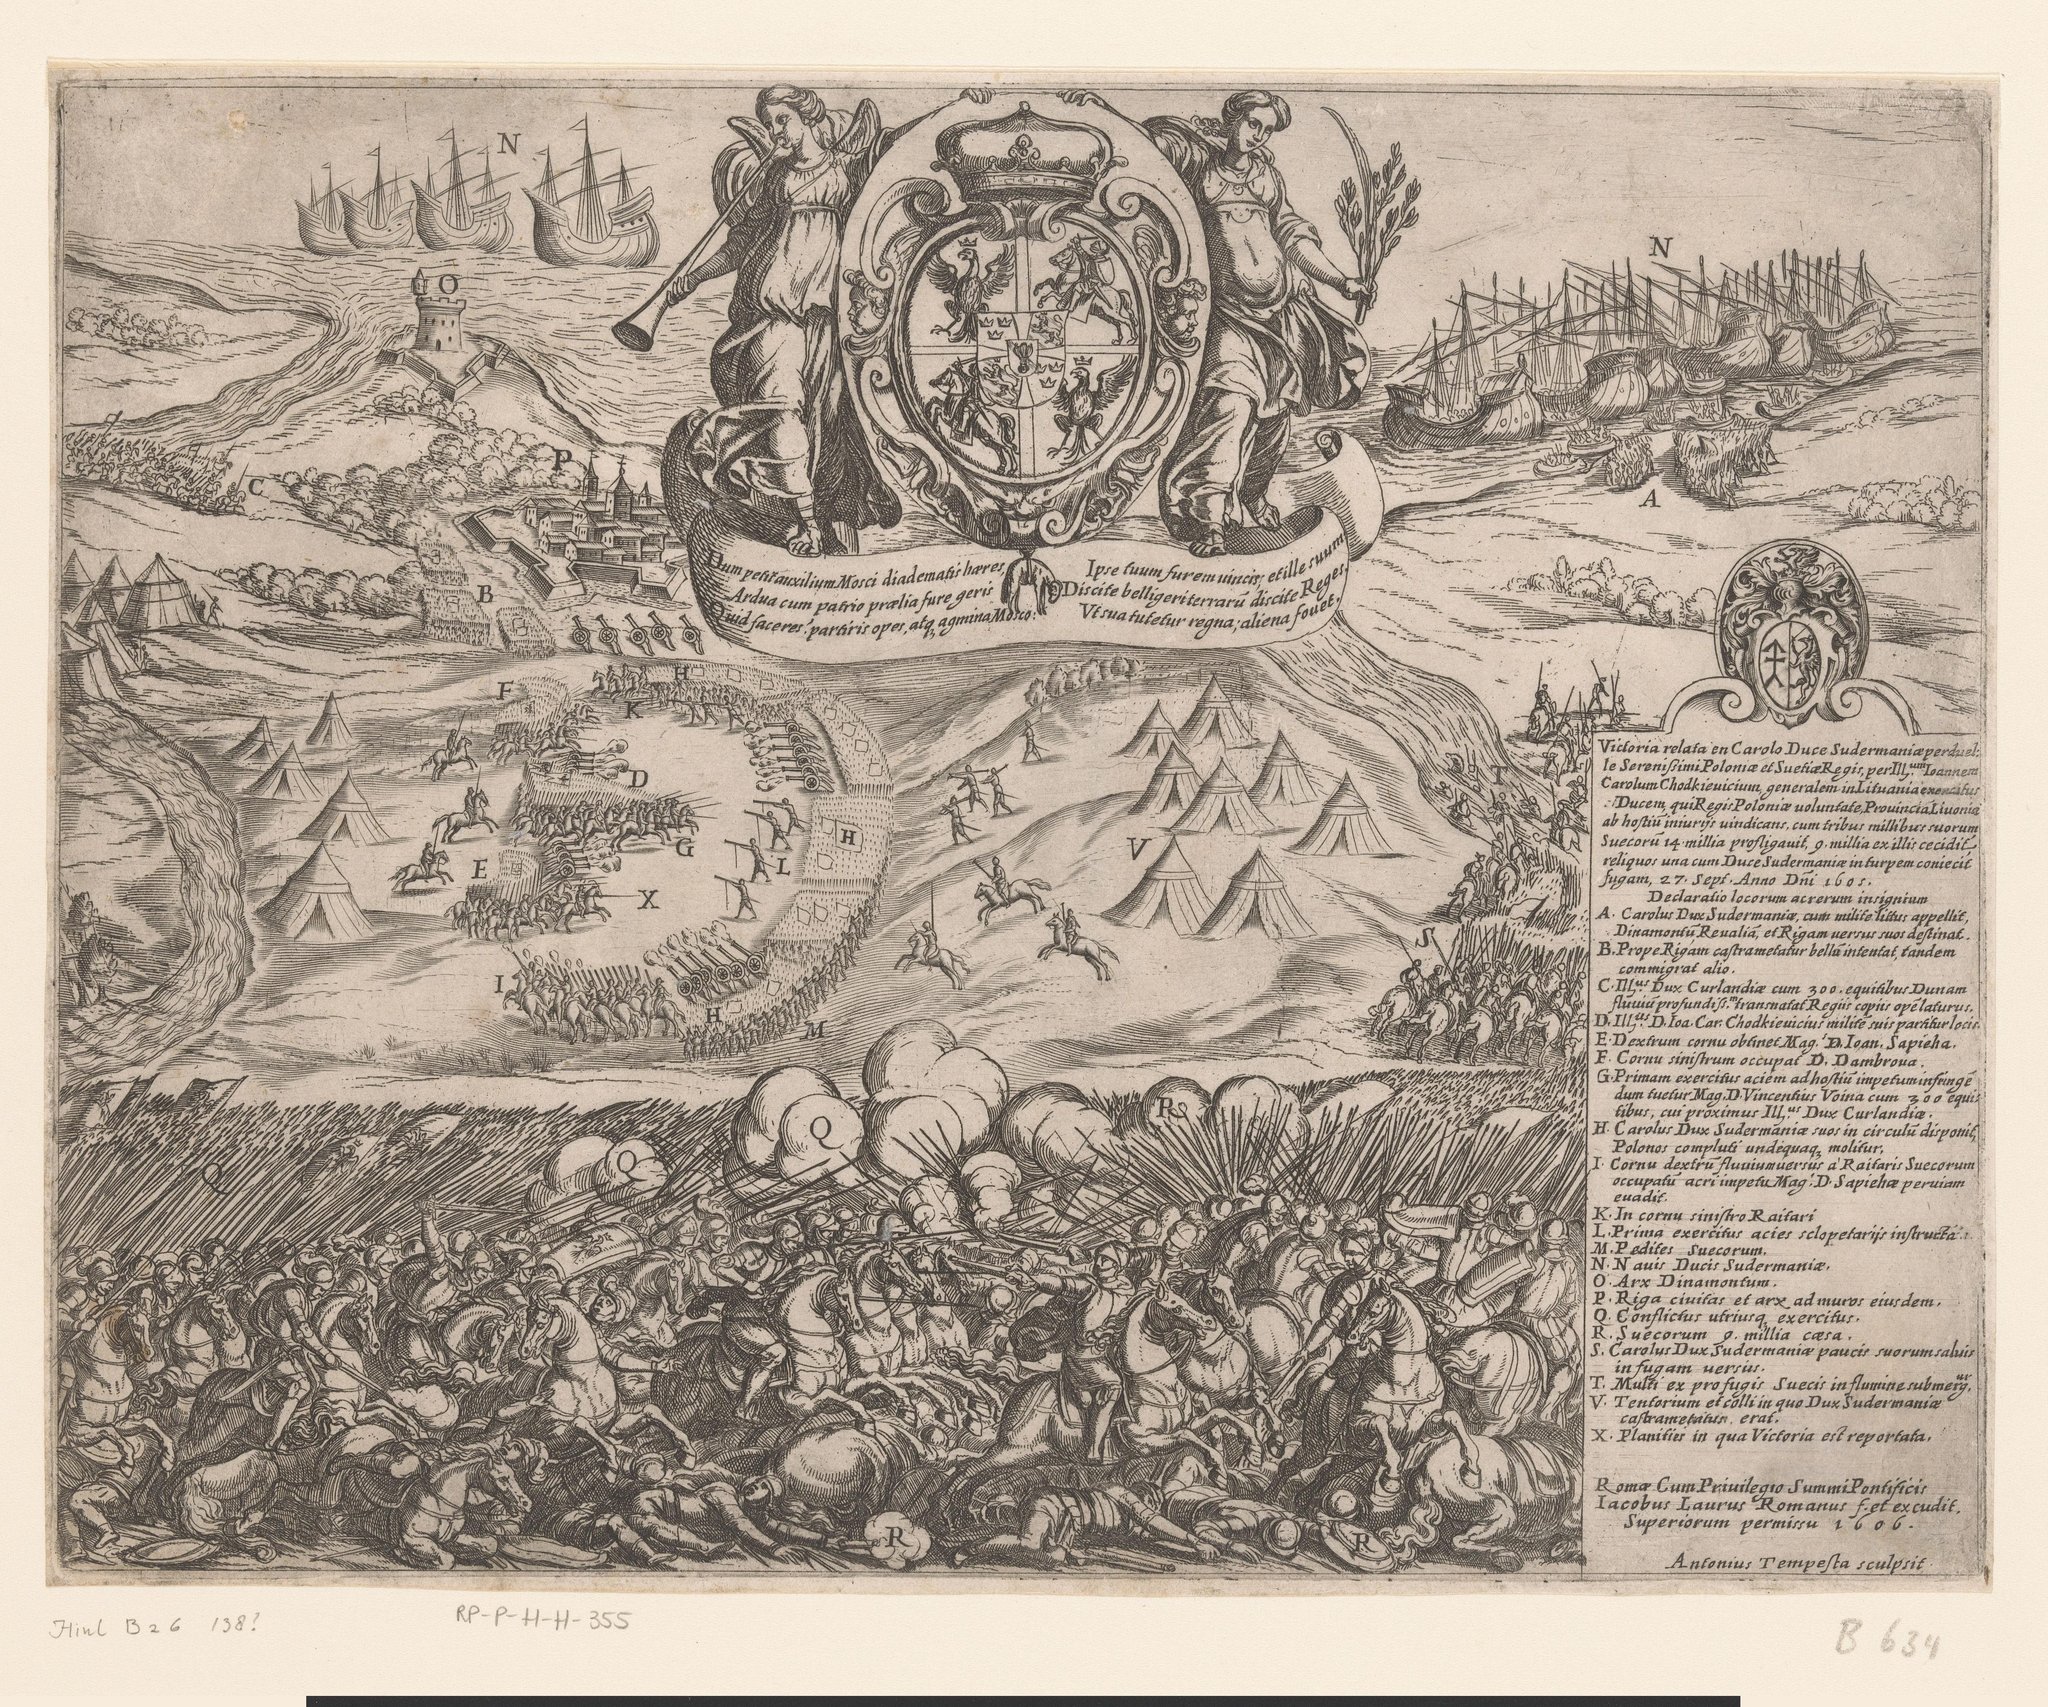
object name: print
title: Strijd tussen de legers van de koning van Polen en Karel, hertog van Sudermanland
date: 1606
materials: paper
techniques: etching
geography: vatican city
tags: battle, warfare; military affairs (+ cavalry, horsemen), the soldier; the soldier's life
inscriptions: date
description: De strijd tussen de legers van de koning van Polen en Karel, hertog van Sudermanland. Op de achtergrond liggen schepen aan de kust. Op de voorgrond soldaten in gevecht. Midden boven een wapenschild tussen twee vrouwelijke personificaties. Rechtsonder een cartouche met een verklarende lijst met letters.